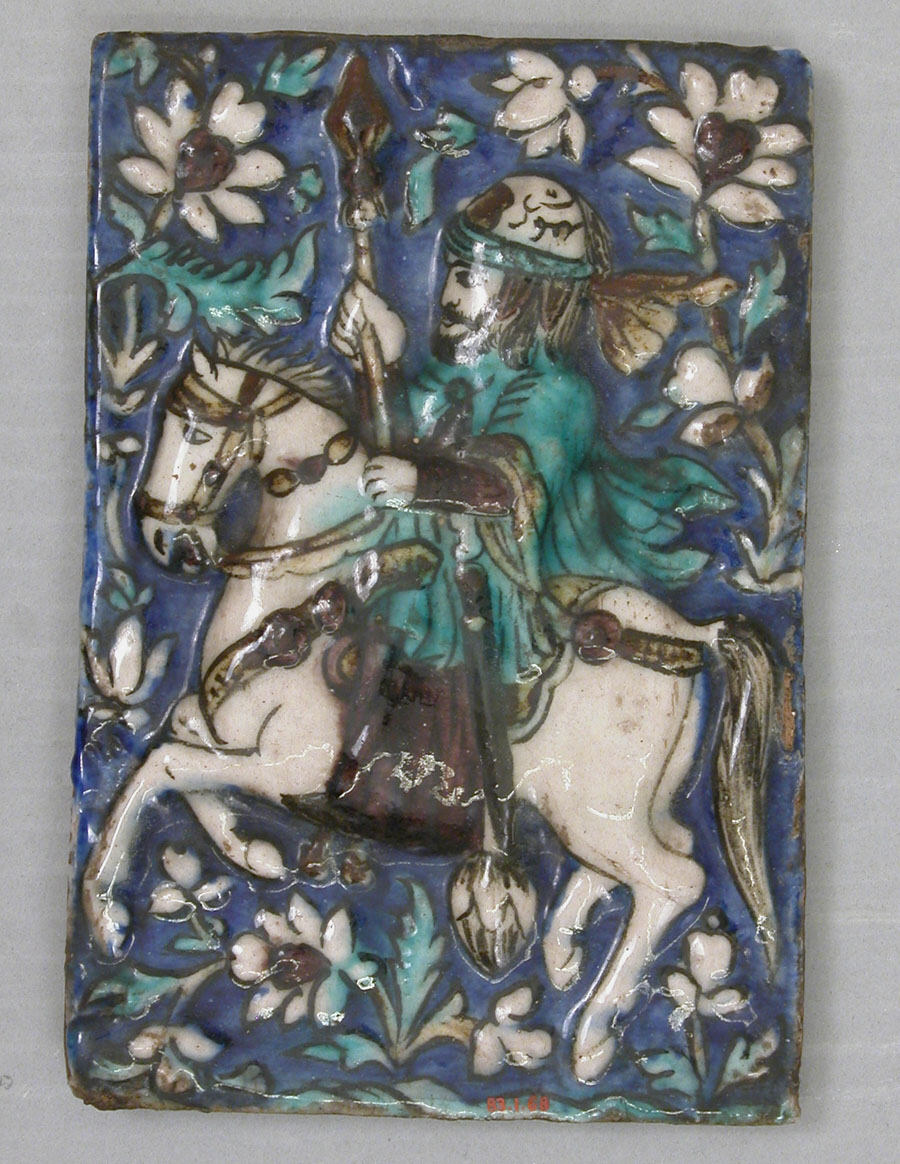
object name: tile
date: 1801-1900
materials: glaze, stonepaste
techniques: molding, painting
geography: iran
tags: men,horses,flowers